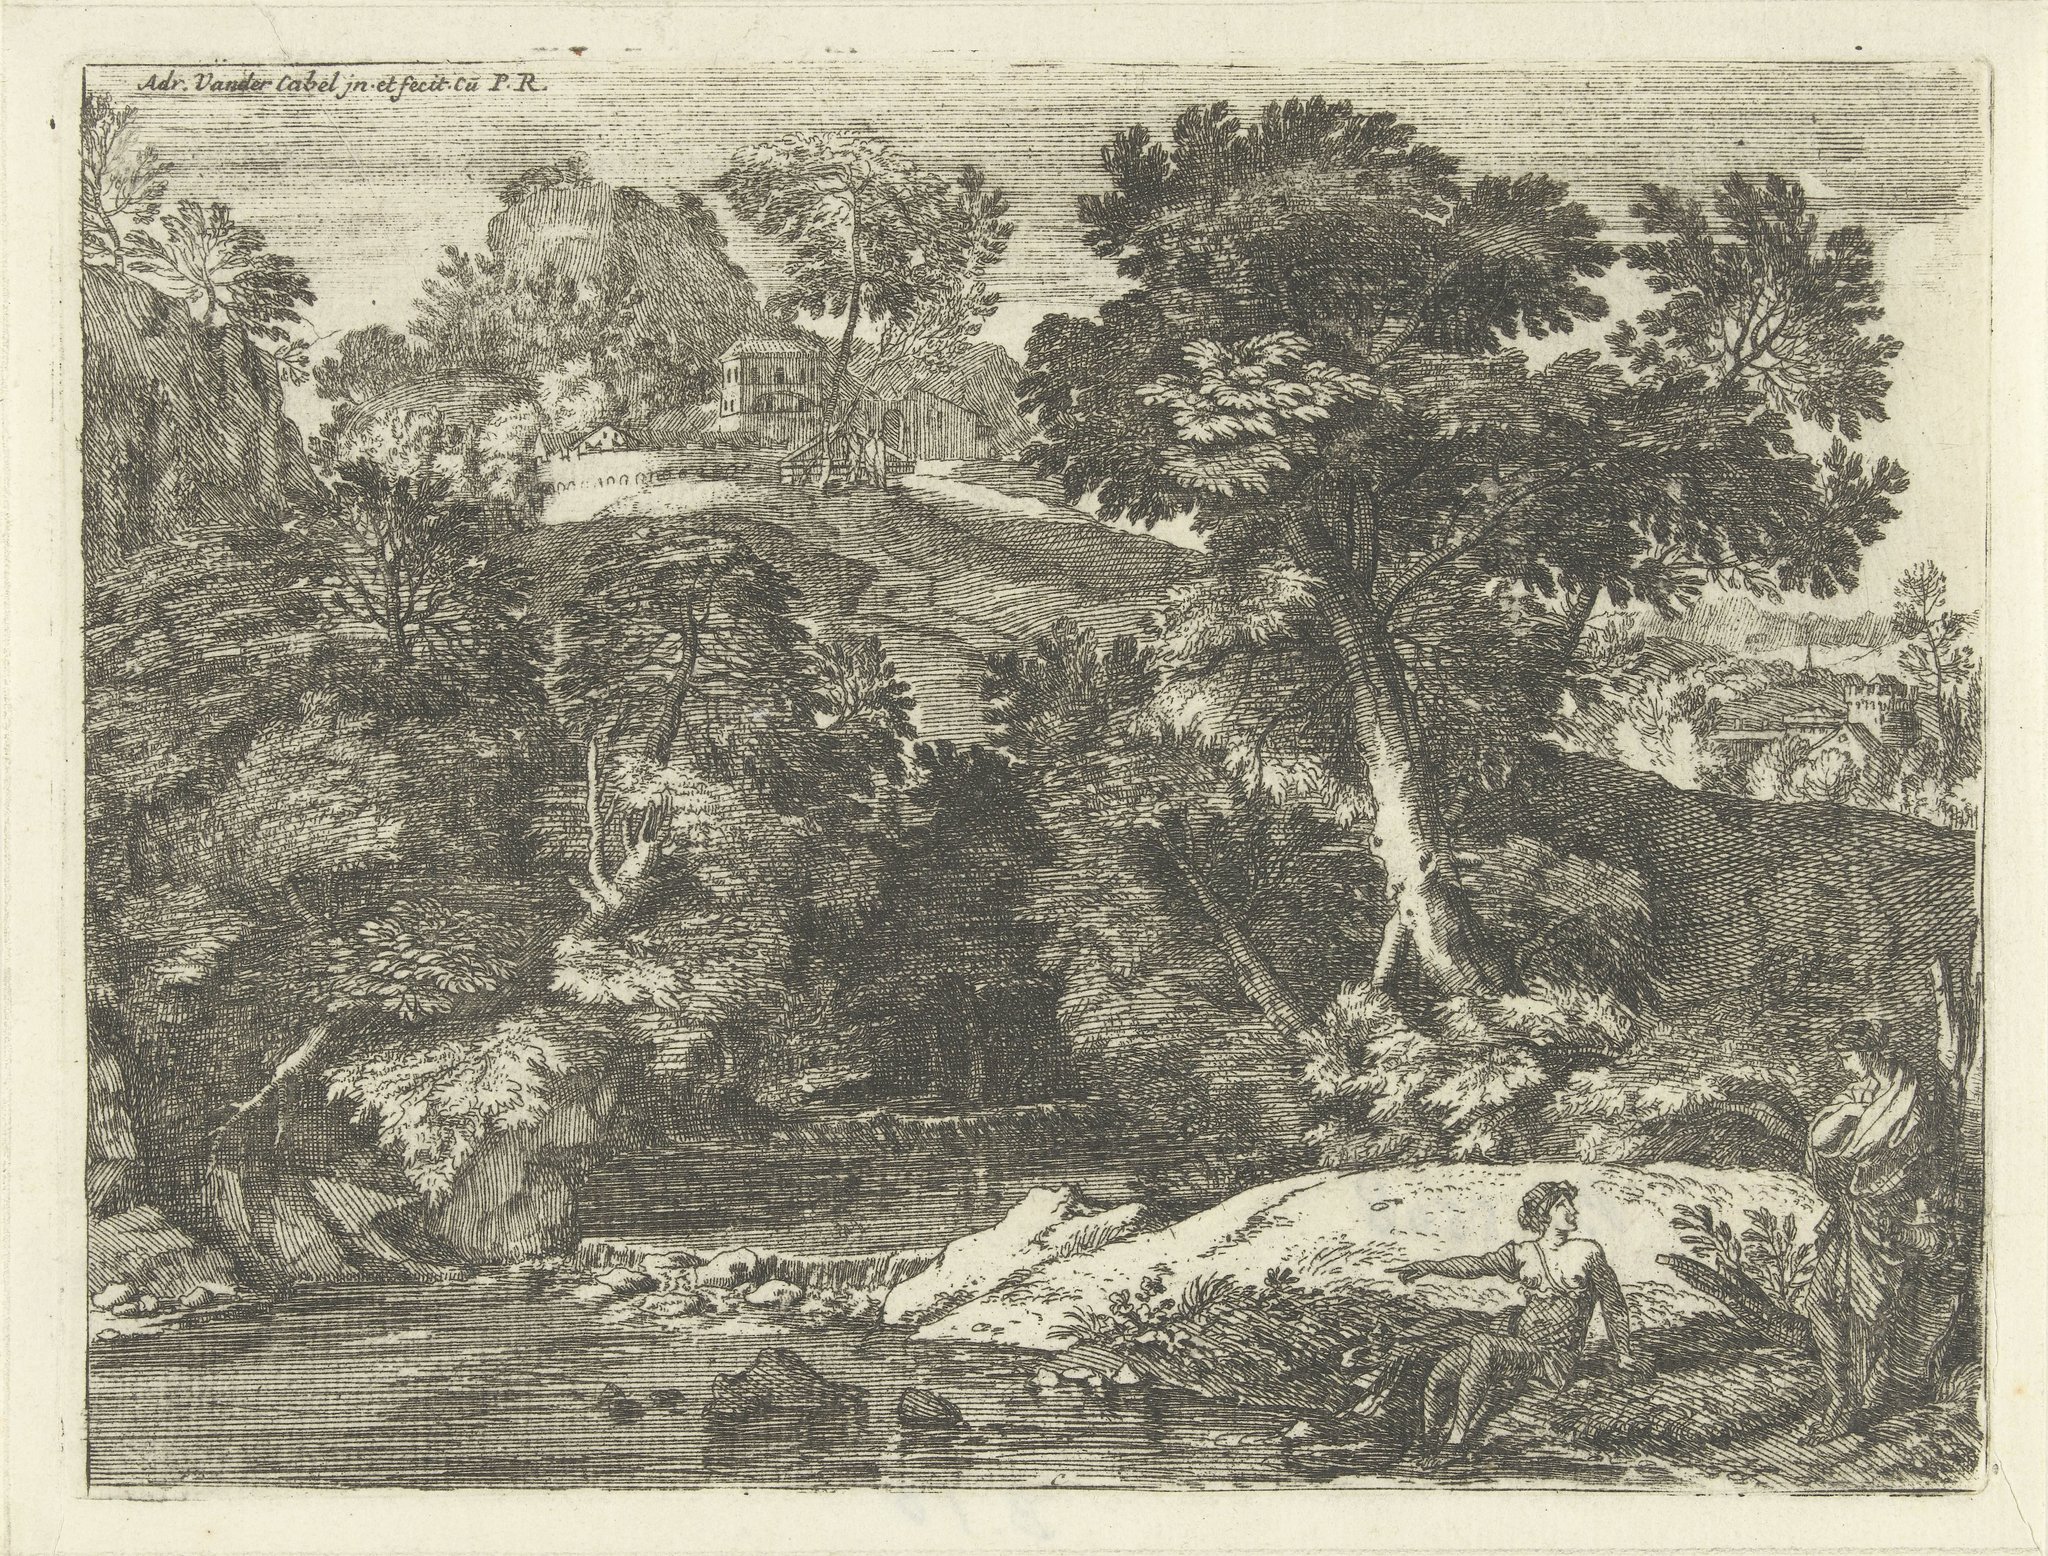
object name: print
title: Landschappen, serie twee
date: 1648-1705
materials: paper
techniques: etching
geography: france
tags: landscapes, washing and bathing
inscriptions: collector's mark: Lugt 240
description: Landschap met schaars geklede wijzende vrouw, de voeten in het water, kijkend naar persoon staand tegen een boomstam. Derde prent uit de serie van zes